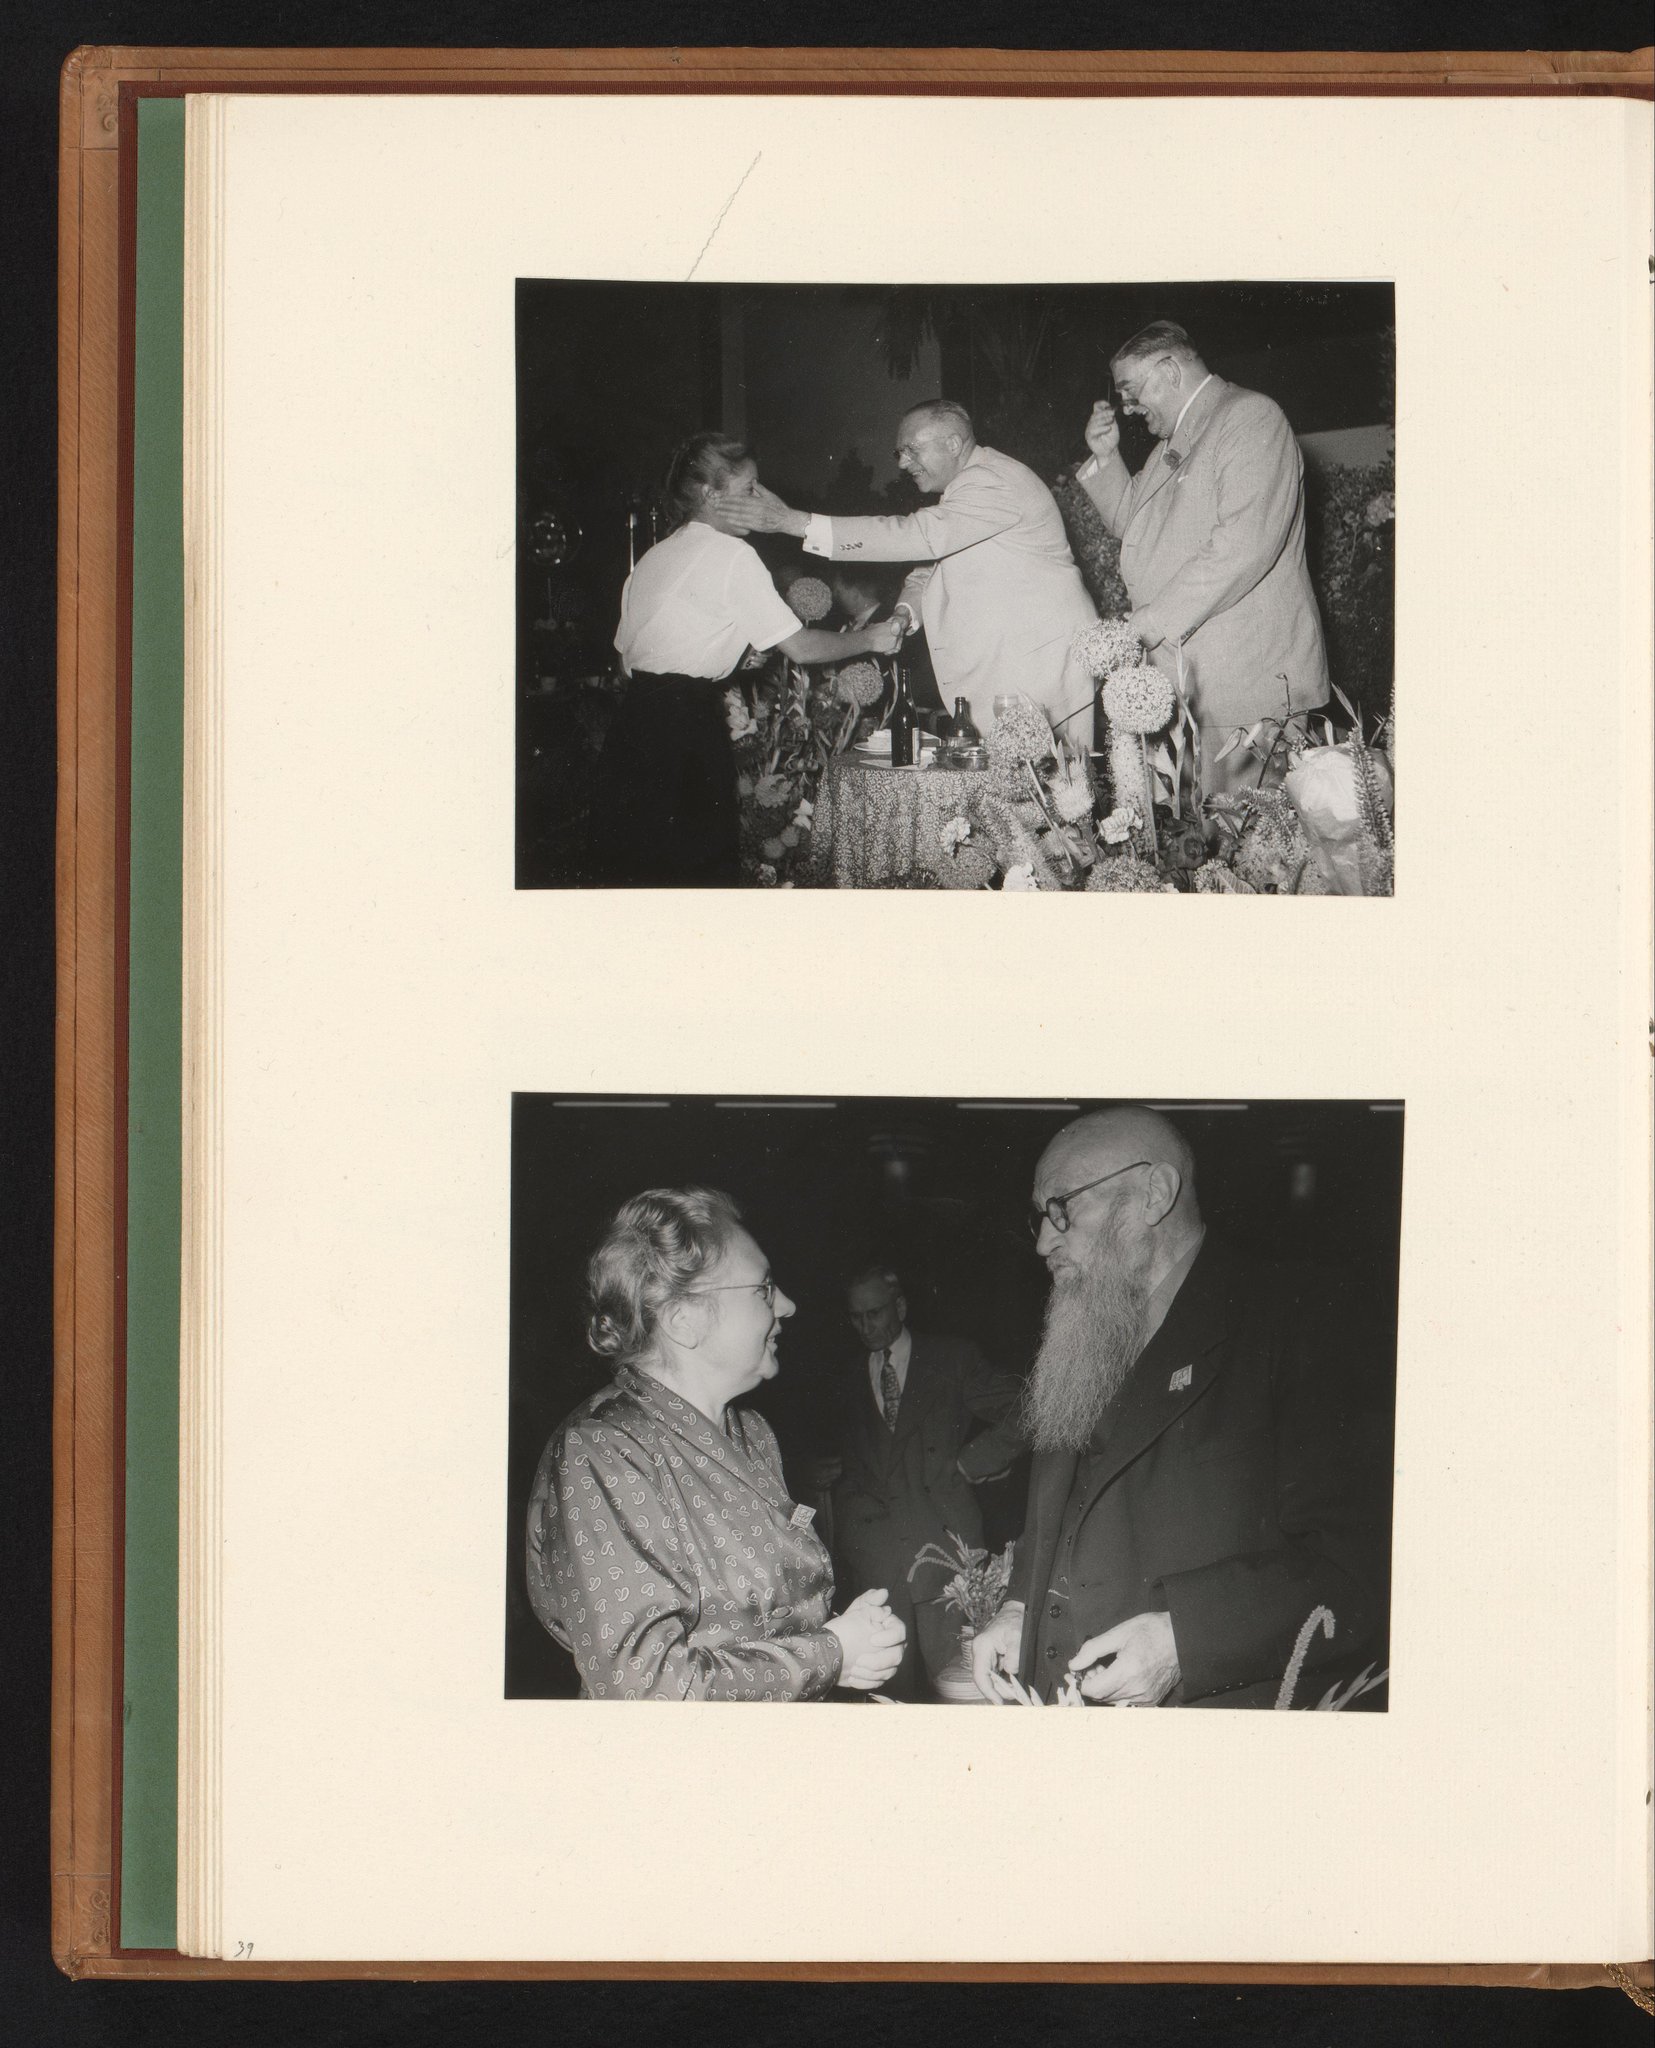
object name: album leaf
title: Afscheid van Kupers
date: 1949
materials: paper, photographic support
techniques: gelatin silver print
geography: amsterdam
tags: shaking hands, 'dextrarum junctio', modern professional organization, trade union, reception, cocktail party, amsterdam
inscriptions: company name: ‘Fotodienst Het Vrije Volk / Hekelveld 15, Amsterdam’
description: Blad met twee foto's waarin Kupers de hand schudt van een jonge vrouw (boven) en een man en een vrouw sprekend met elkaar (onder). Onderdeel van het fotoalbum ter gelegenheid van het afscheid van Evert Kupers als voorzitter van de NVV op 14 juli 1949 in Amsterdam.